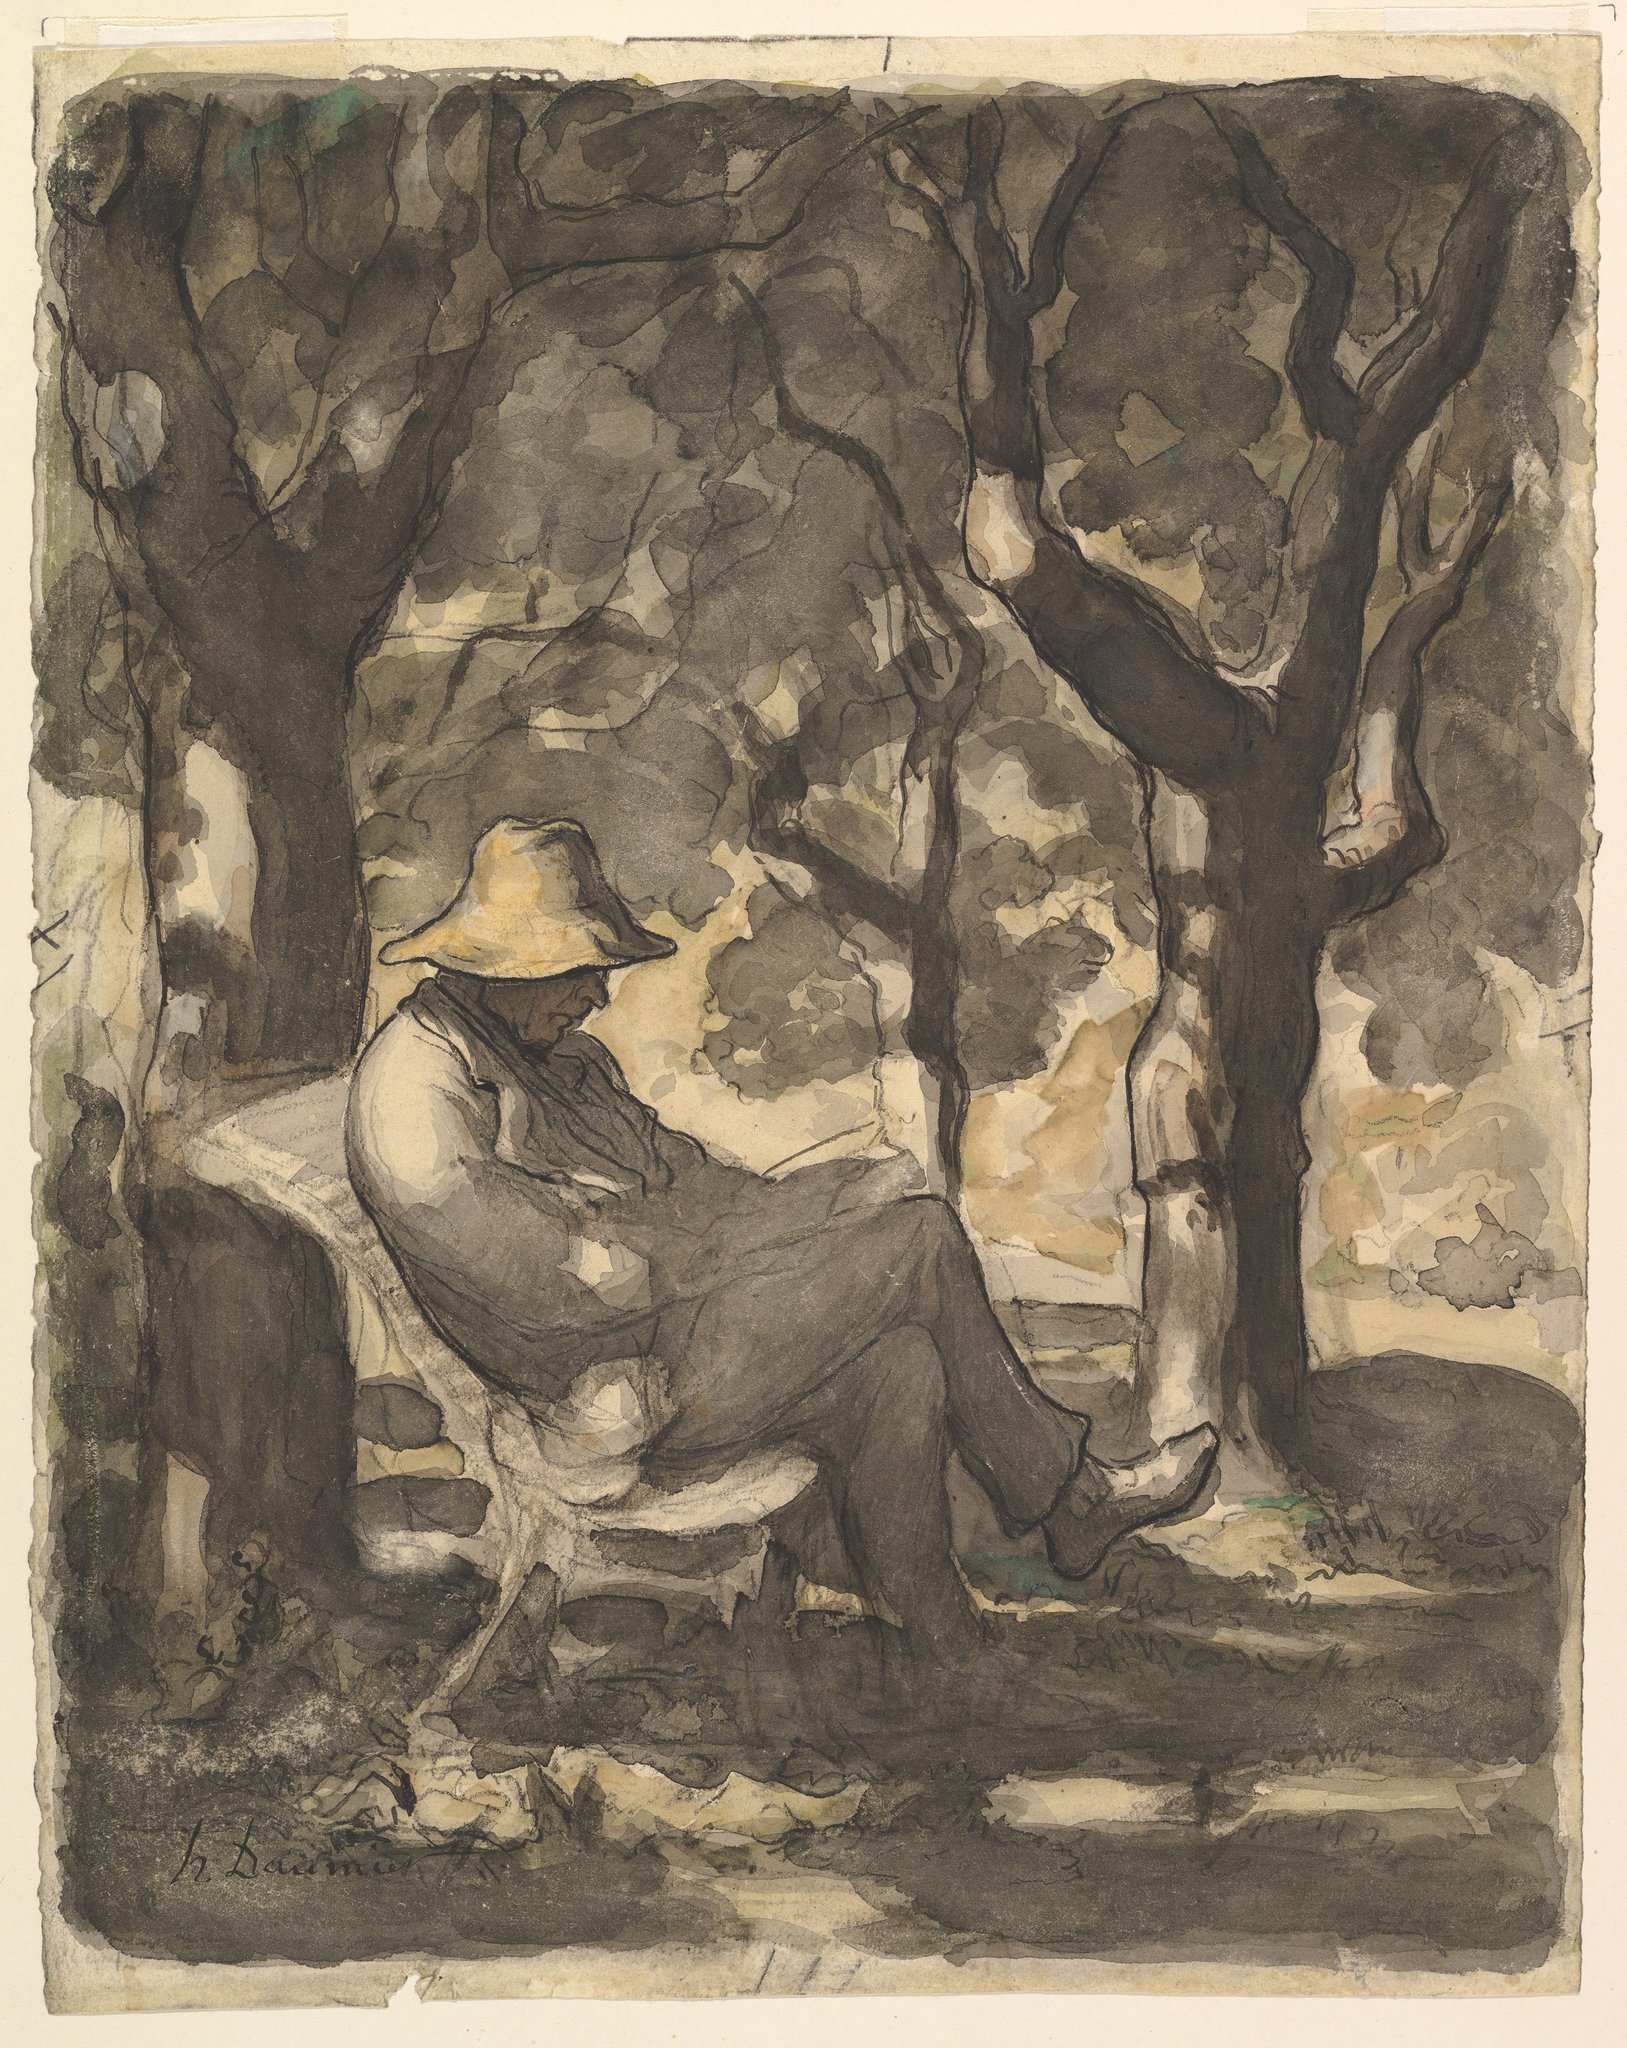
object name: drawing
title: A Man Reading in a Garden (recto); Preliminary sketch for a Man Reading in a Garden (verso)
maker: honoré daumier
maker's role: artist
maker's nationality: french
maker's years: 1808-1879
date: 1865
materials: chalk, crayon, ink, watercolor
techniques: brush, lithograph, pen, wash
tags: gardens,men,reading